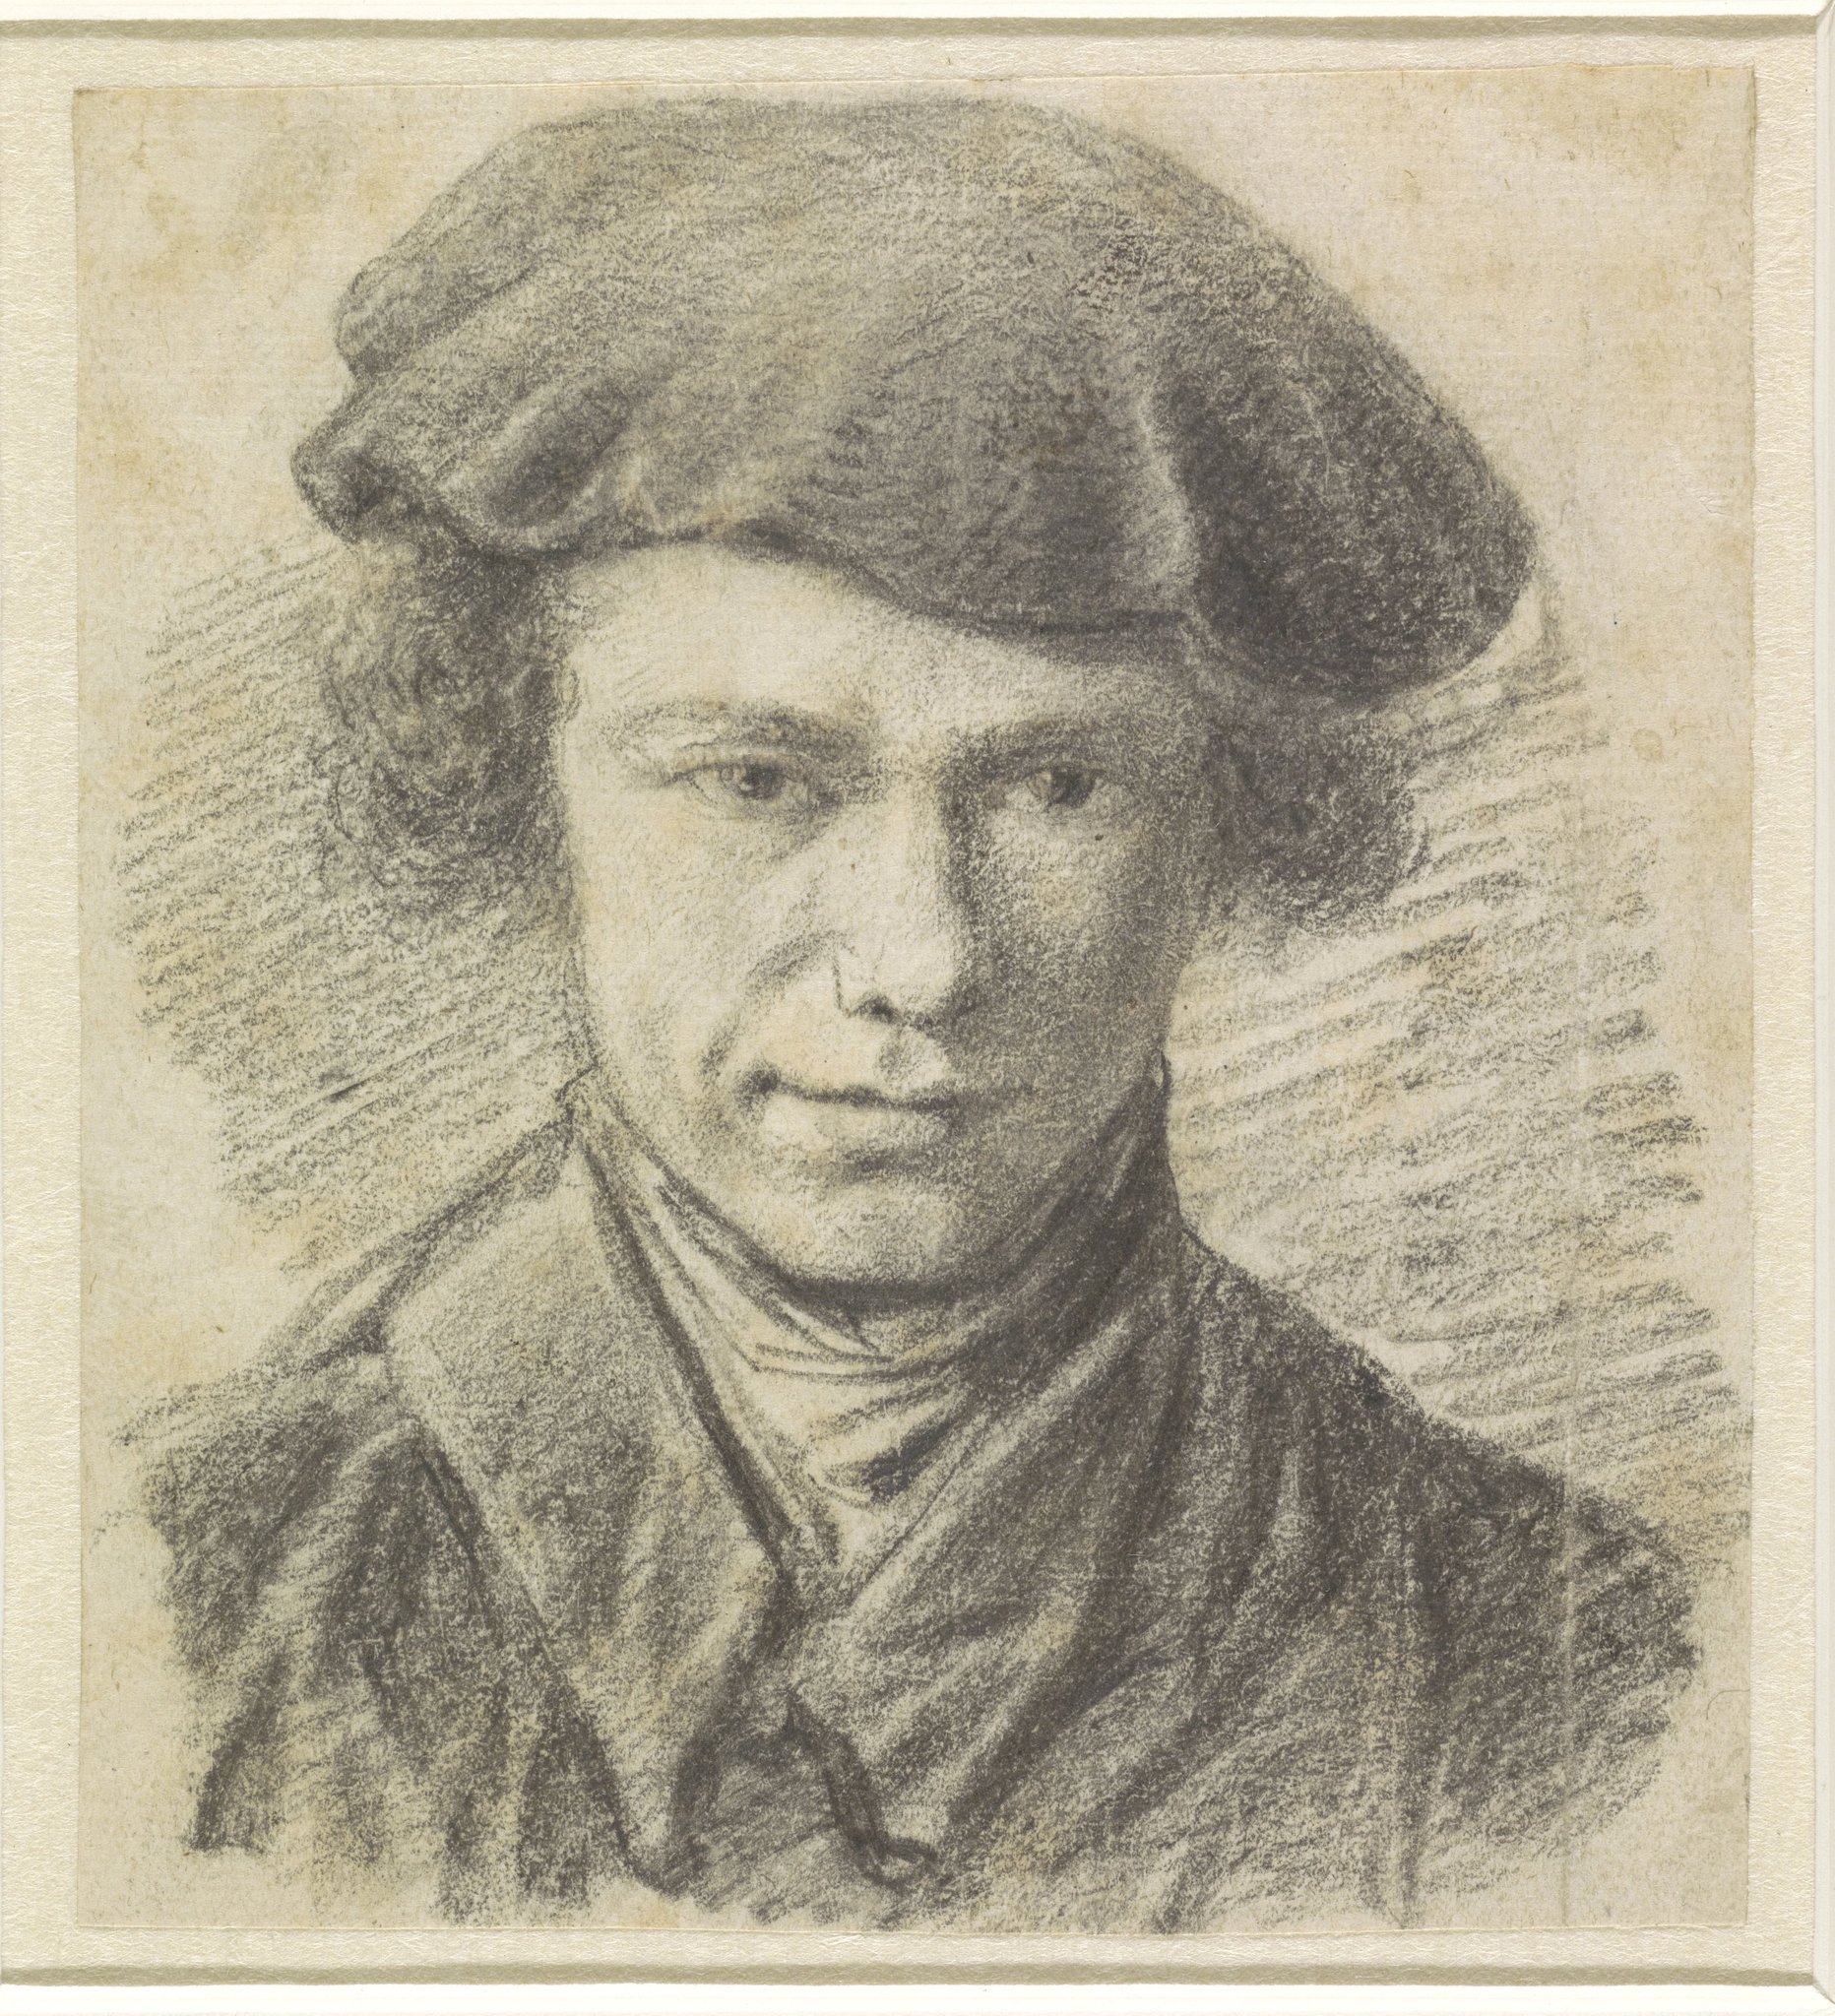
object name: drawing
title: Zelfportret met baret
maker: barend cornelis koekkoek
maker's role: draughtsman, painter, print maker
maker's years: 1803-1862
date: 1813-1862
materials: chalk, paper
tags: middelburg, cleves, painter, print maker, draughtsman, barend cornelis koekkoek, historical persons, portrait, self-portrait of painter, portrait, self-portrait of artist